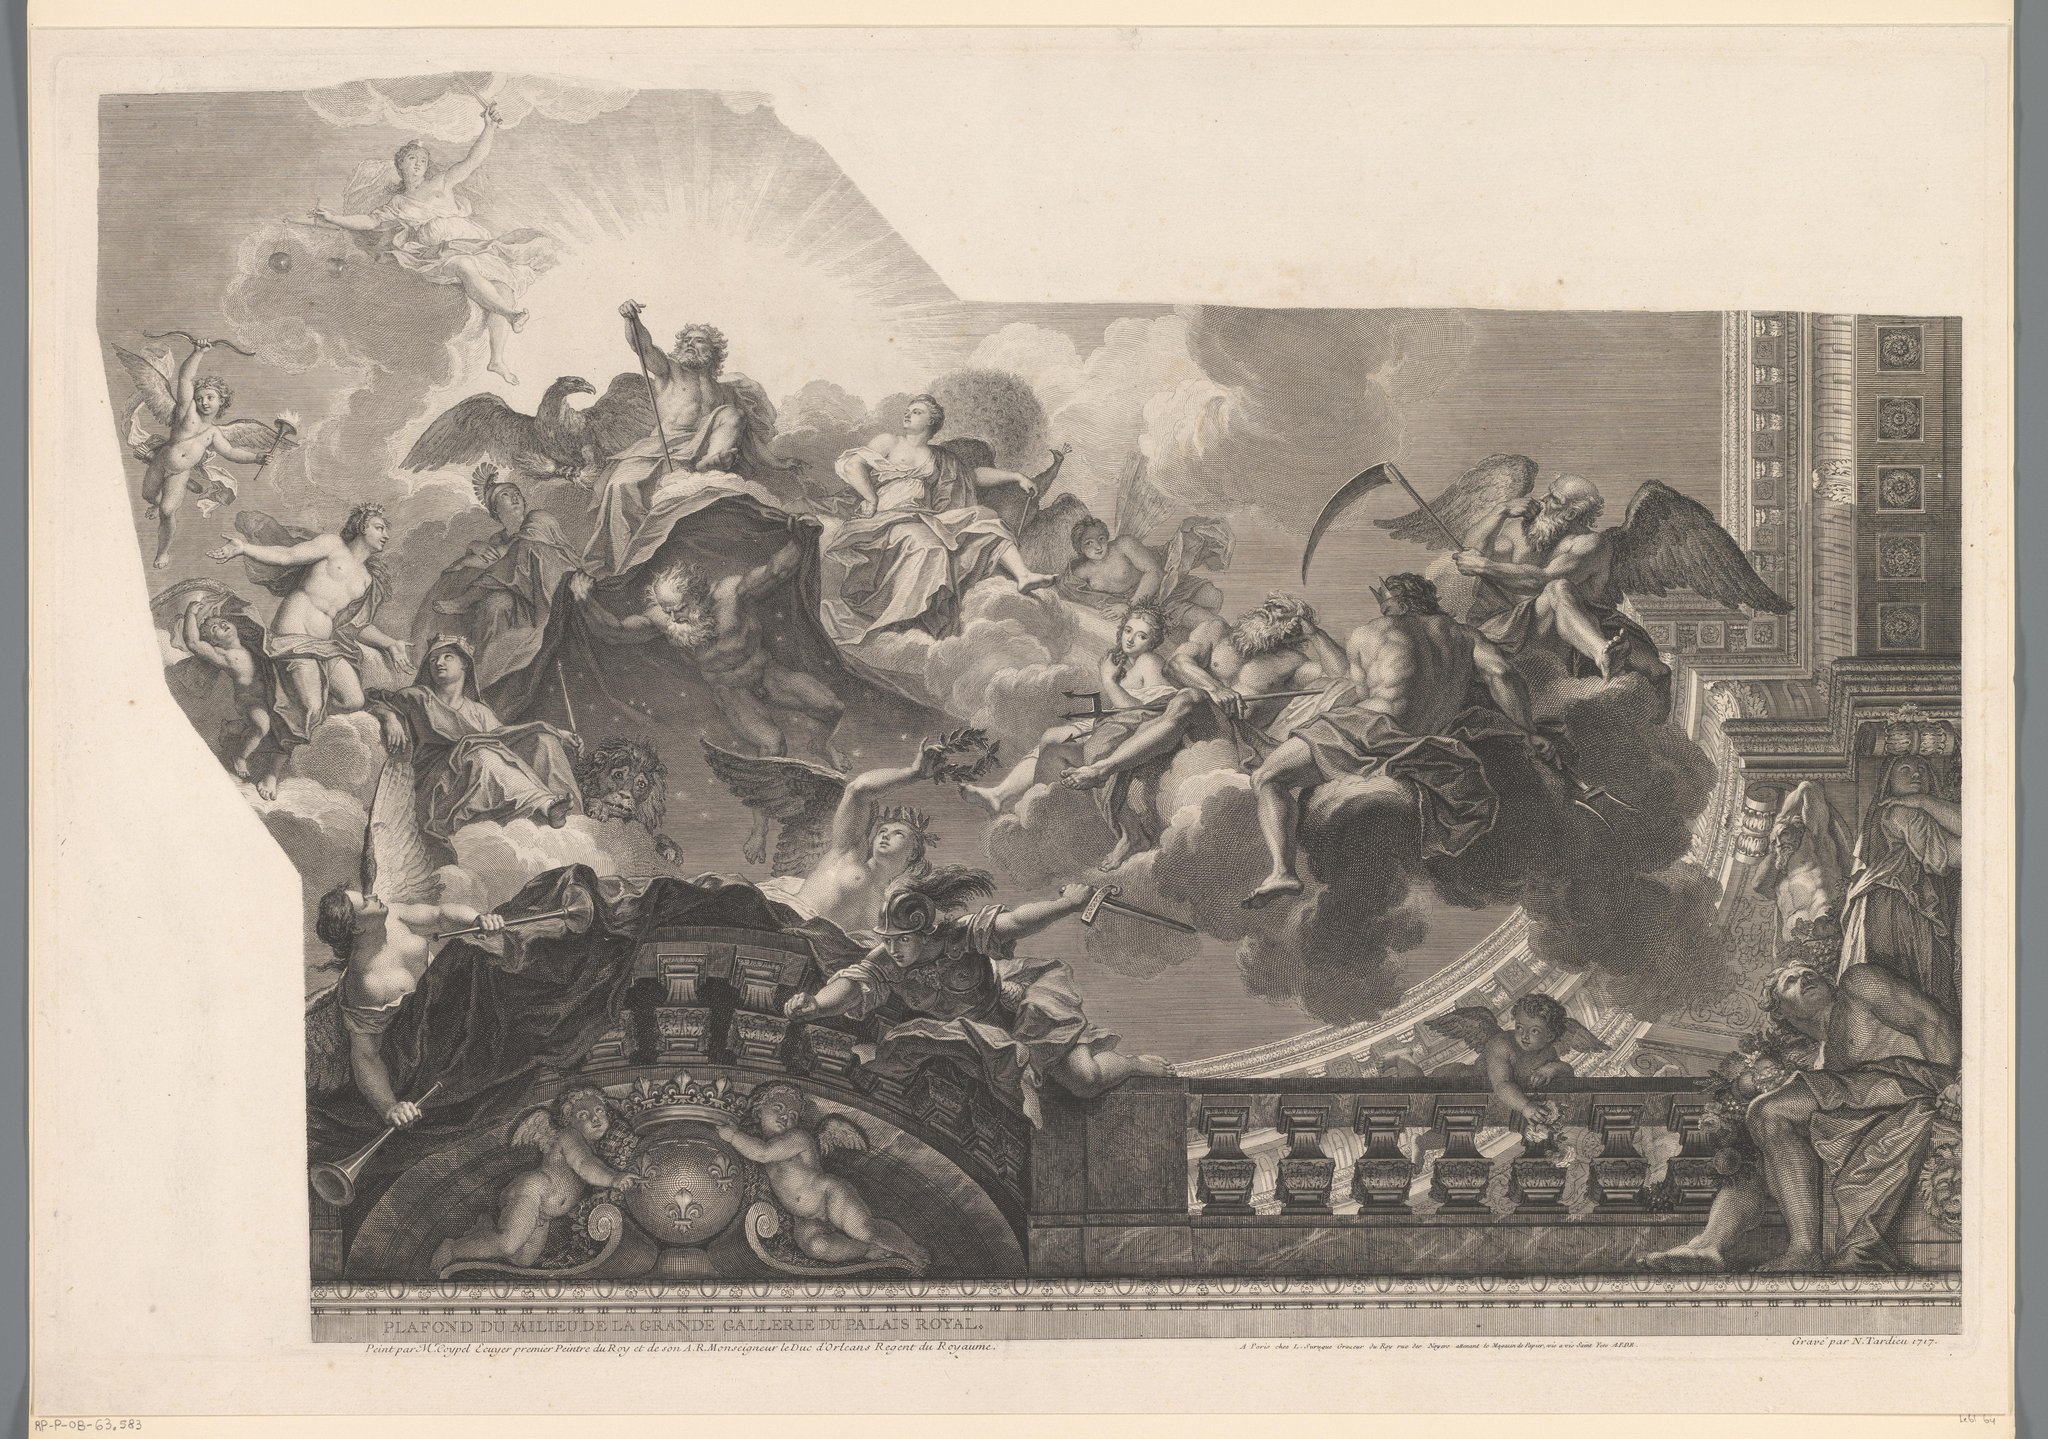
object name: print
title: Venus als tussenpersoon voor Aeneas bij de goden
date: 1717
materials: paper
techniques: engraving, etching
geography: paris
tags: (story of) jupiter (zeus), gods of the waters: neptune and his environment, personification of the night, 'nox'; 'notte', 'carro della notte', 'serenità della notte' (ripa), the story of aeneas' wanderings to italy (virgil, aeneid), (story of) cupid, amor (eros), (story of) venus (aphrodite), father time, man with wings and scythe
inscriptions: date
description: Serie prenten naar schilderijen van Coypel met als thema de Aeneas van Virgilius, in de Galerie van het Palais Royal.